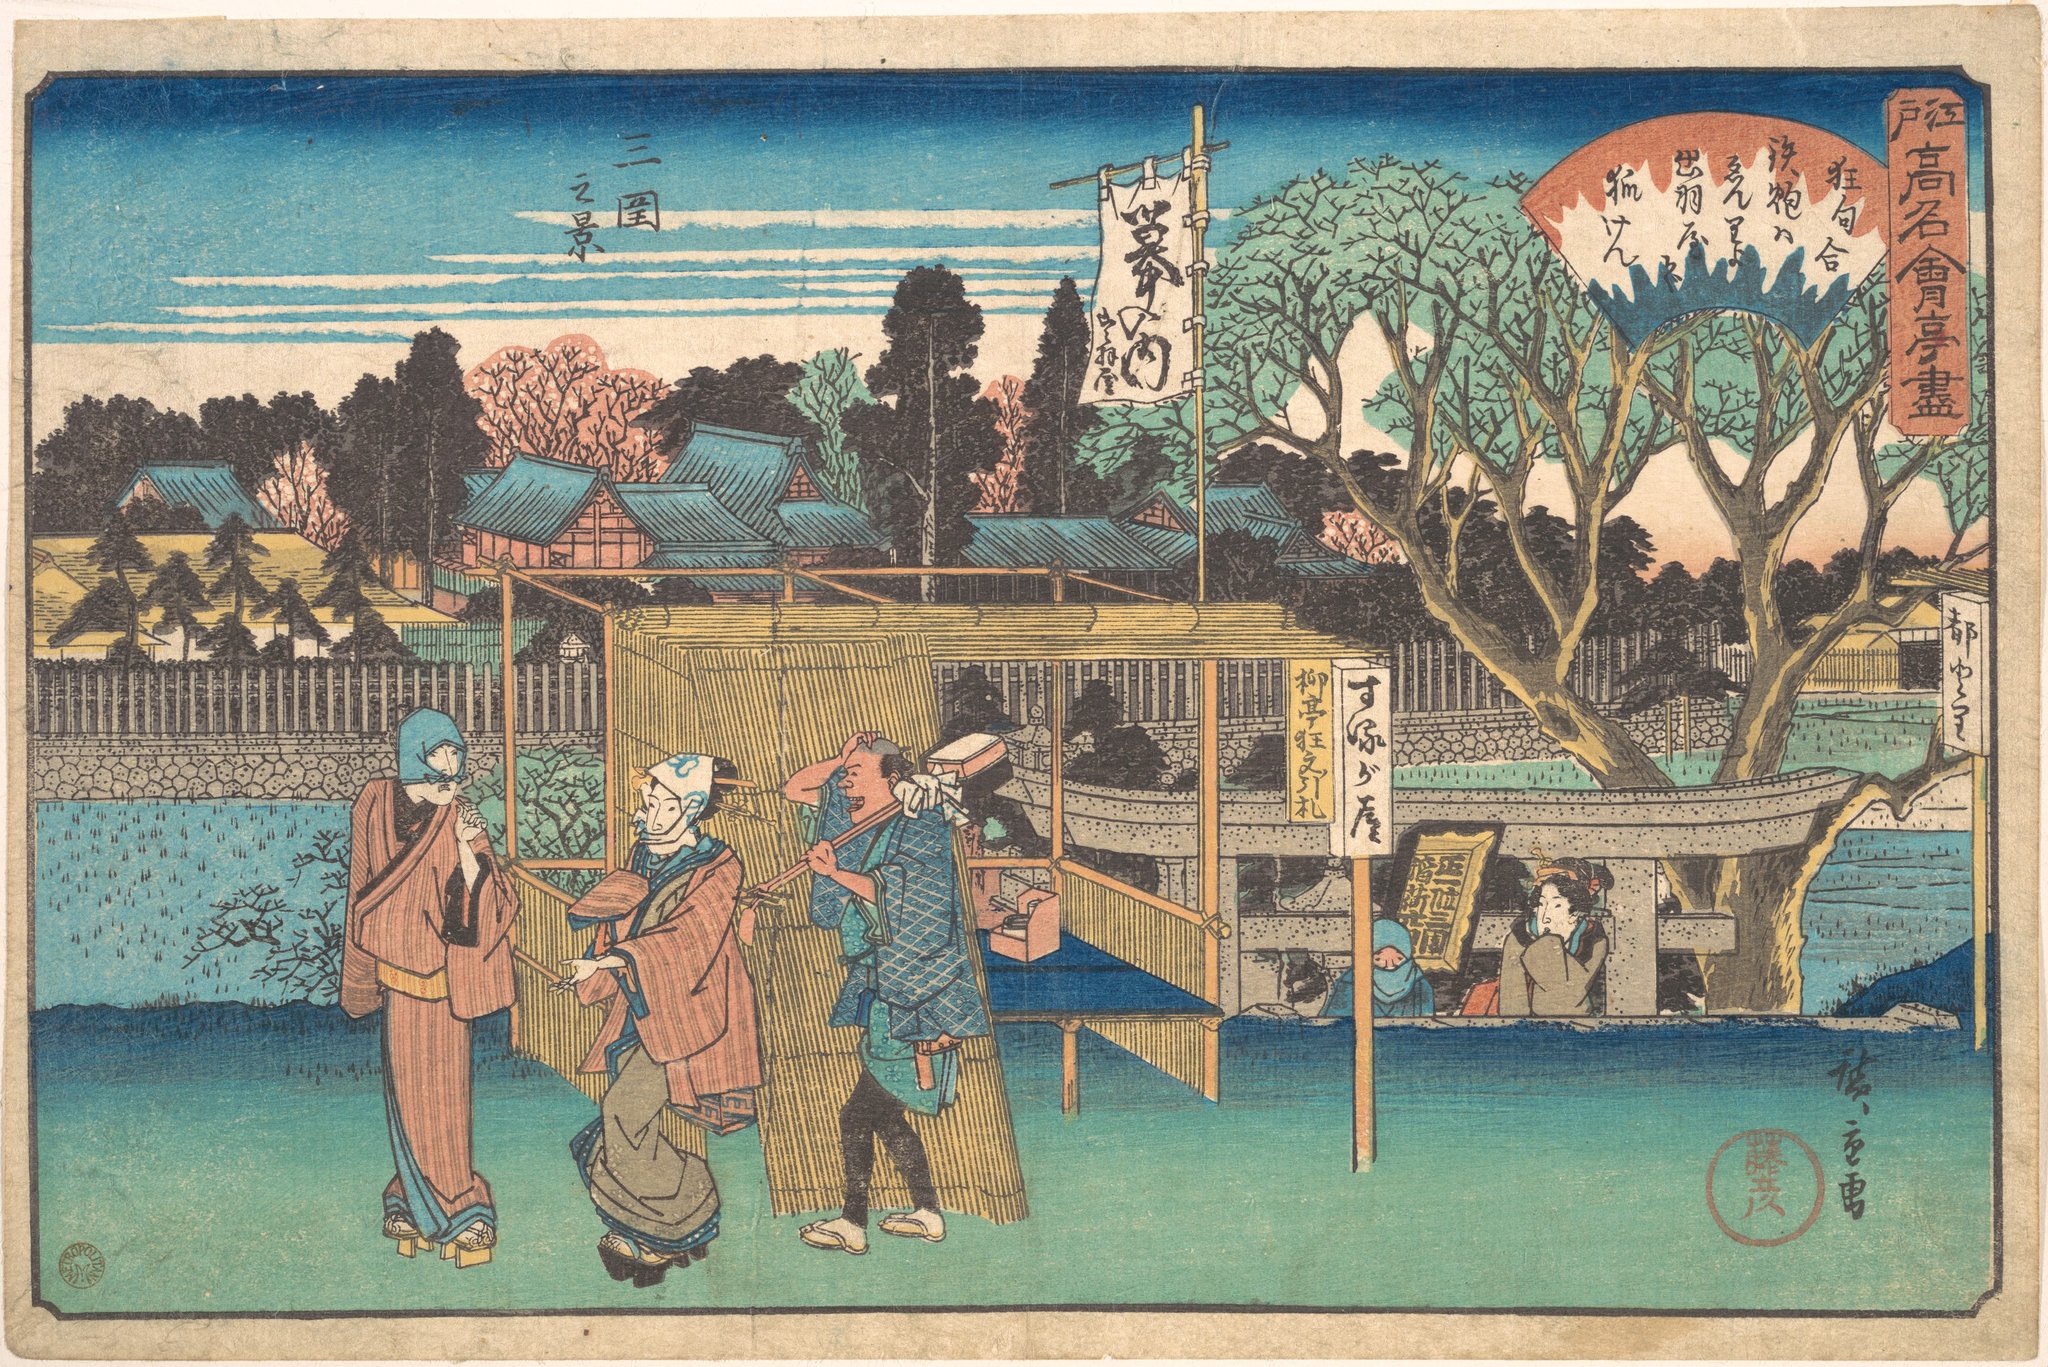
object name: print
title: Mimeguri no Kei (Toyoha-ya)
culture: japanese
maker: utagawa hiroshige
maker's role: artist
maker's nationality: japanese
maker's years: 1797-1858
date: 1840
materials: ink, paper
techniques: woodblock print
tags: musical instruments,gates,men,women